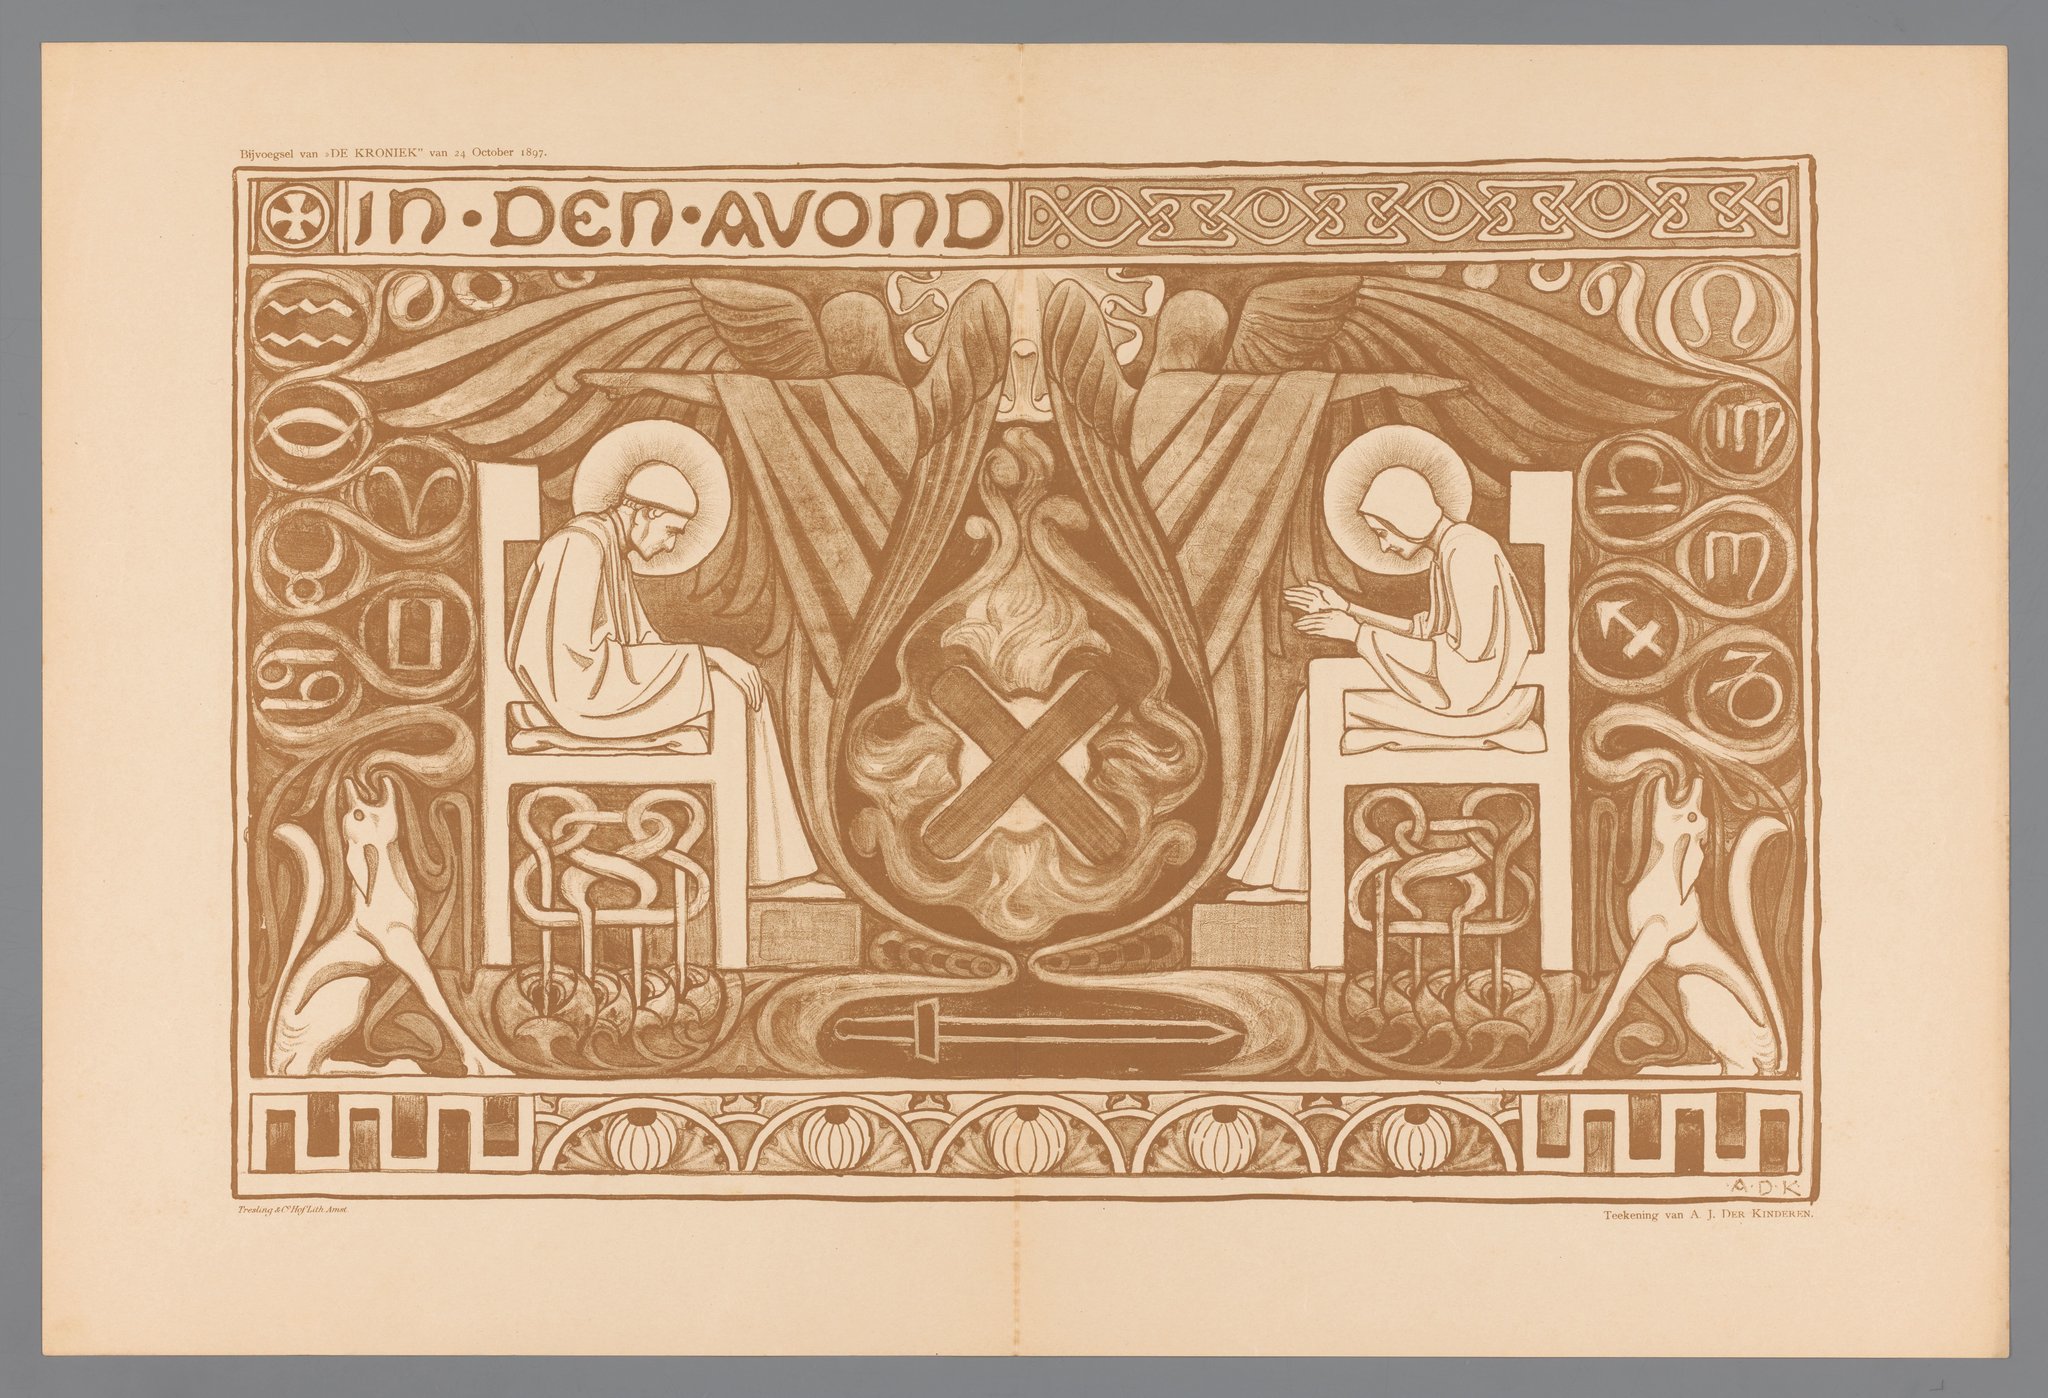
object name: print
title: In den avond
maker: antoon derkinderen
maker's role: draughtsman, painter, print maker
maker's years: 1859-1925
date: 1897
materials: paper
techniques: lithograph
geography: amsterdam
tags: sitting figure, evening, open fire (in general), zodiac; the twelve zodiacal signs together, fabulous beings with wings, hearth and stove, dog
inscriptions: date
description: Een man en vrouw staren in een vuur waarin balken in de vorm van een andreaskruis branden. Onder het vuur een zwaard. Uit het vuur stijgen twee gevleugelde figuren op die hun arm uitstrekken boven het hoofd van de man en vrouw. Uiterst links en uiterst rechts produceren twee honden golvende klanklijnen met daarin tekens uit de dierenriem.